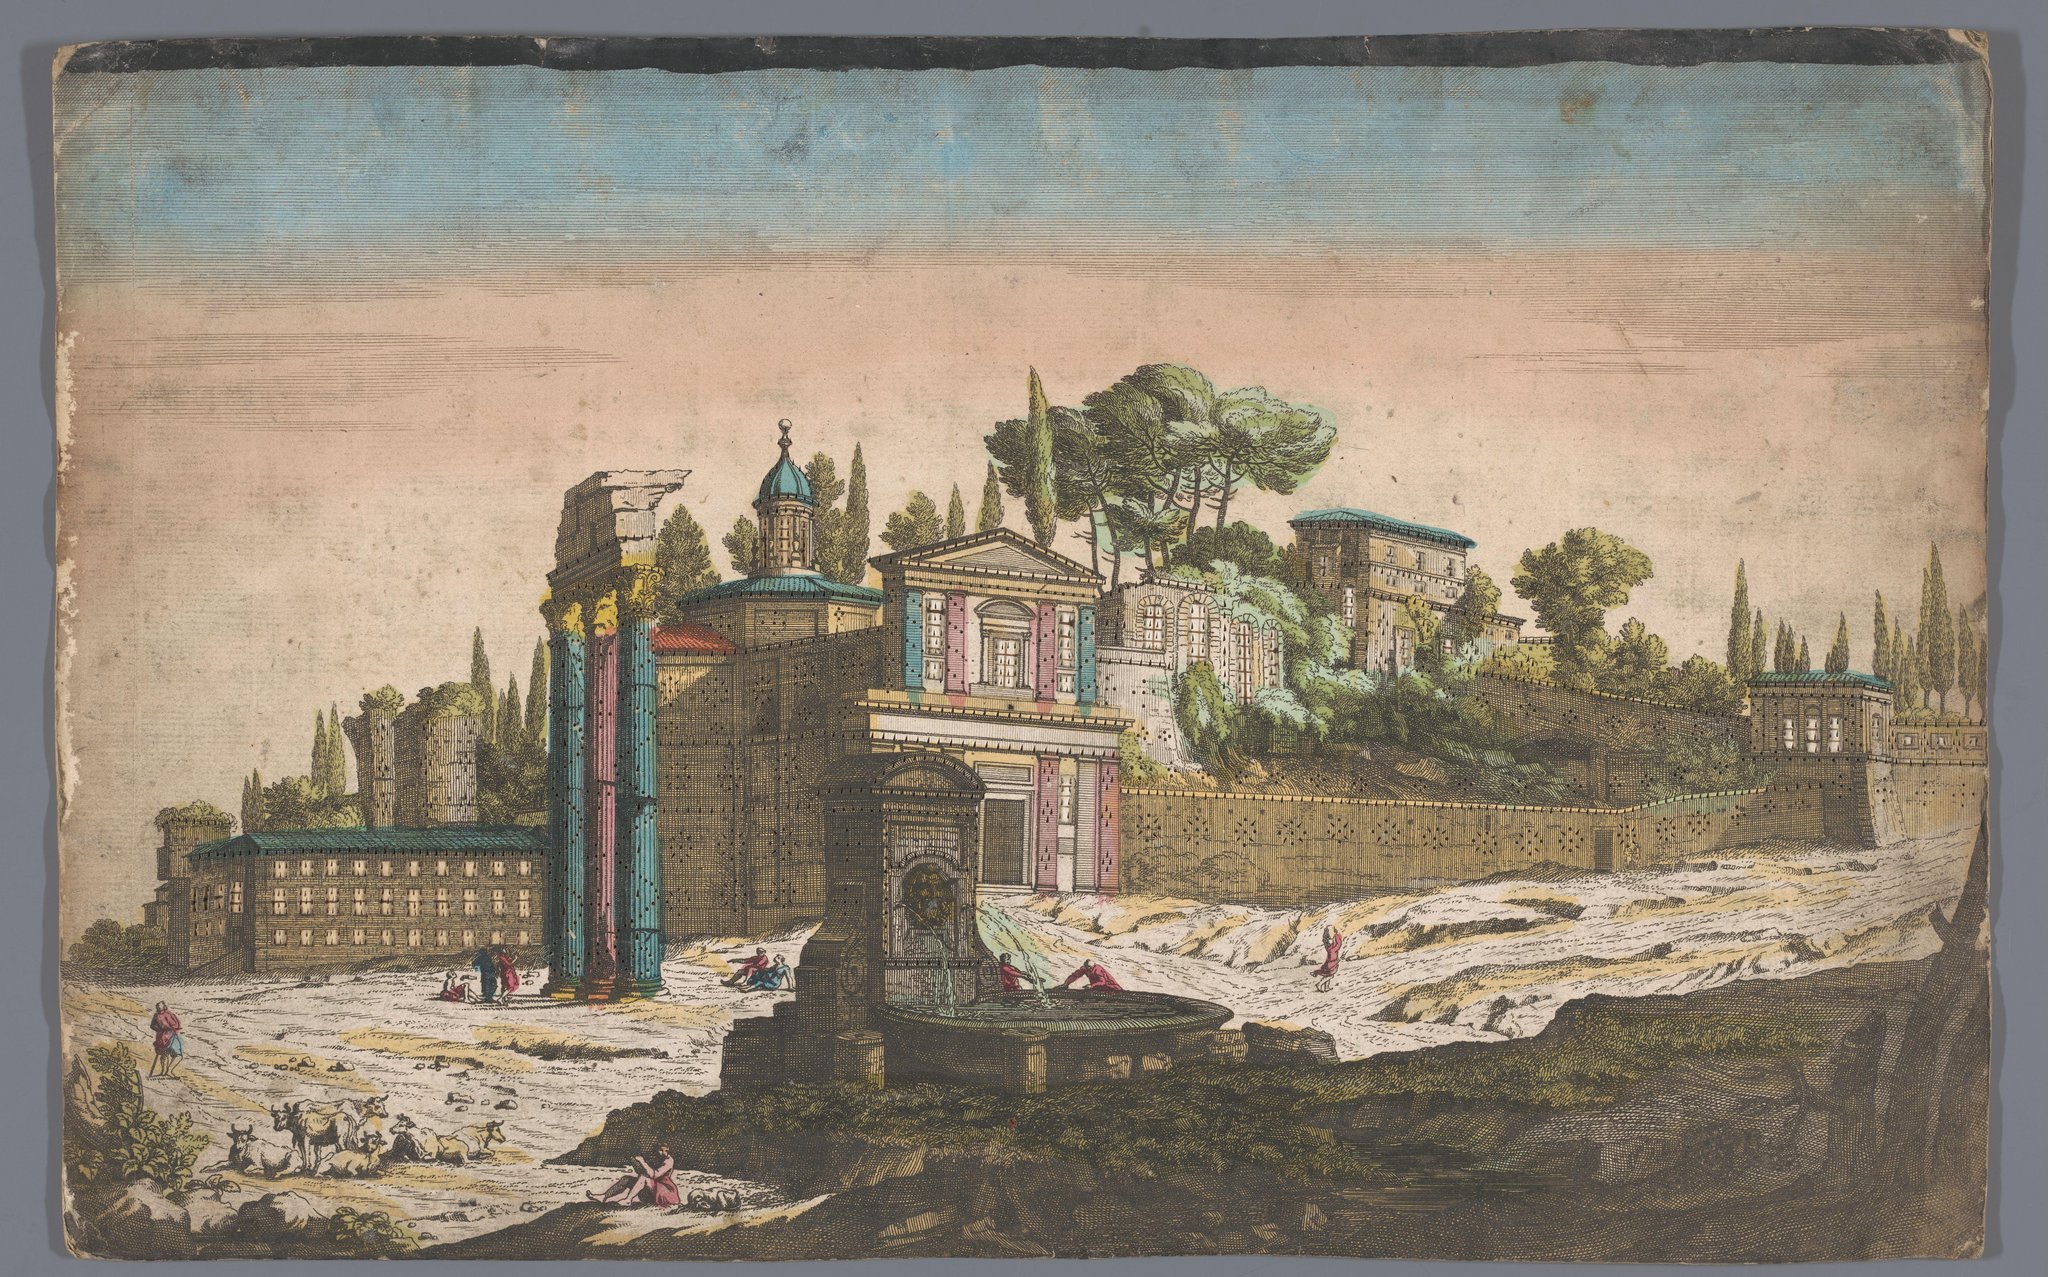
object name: print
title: Veuë du marché Romain appellé Campo Vacino, d'ou l'on voit les ruines du Palais Majeur des Empereurs, et la vigne farnese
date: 1700-1799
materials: cardboard, paint, paper, watercolor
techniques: brush, cutting, etching, perforating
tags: landscape with ruins (+ city(-scape) with figures, staffage), square, place, circus, etc. (+ city(-scape) with figures, staffage), street (+ city(-scape) with figures, staffage)